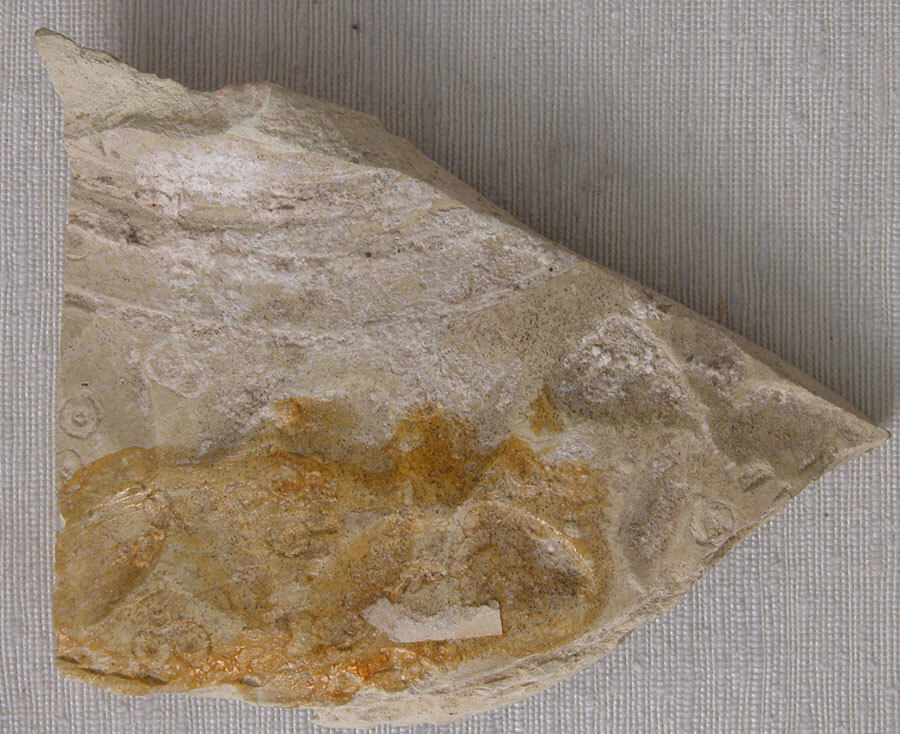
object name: fragment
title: Ceramic Fragment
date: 801-1000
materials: earthenware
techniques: incising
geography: saudi arabia